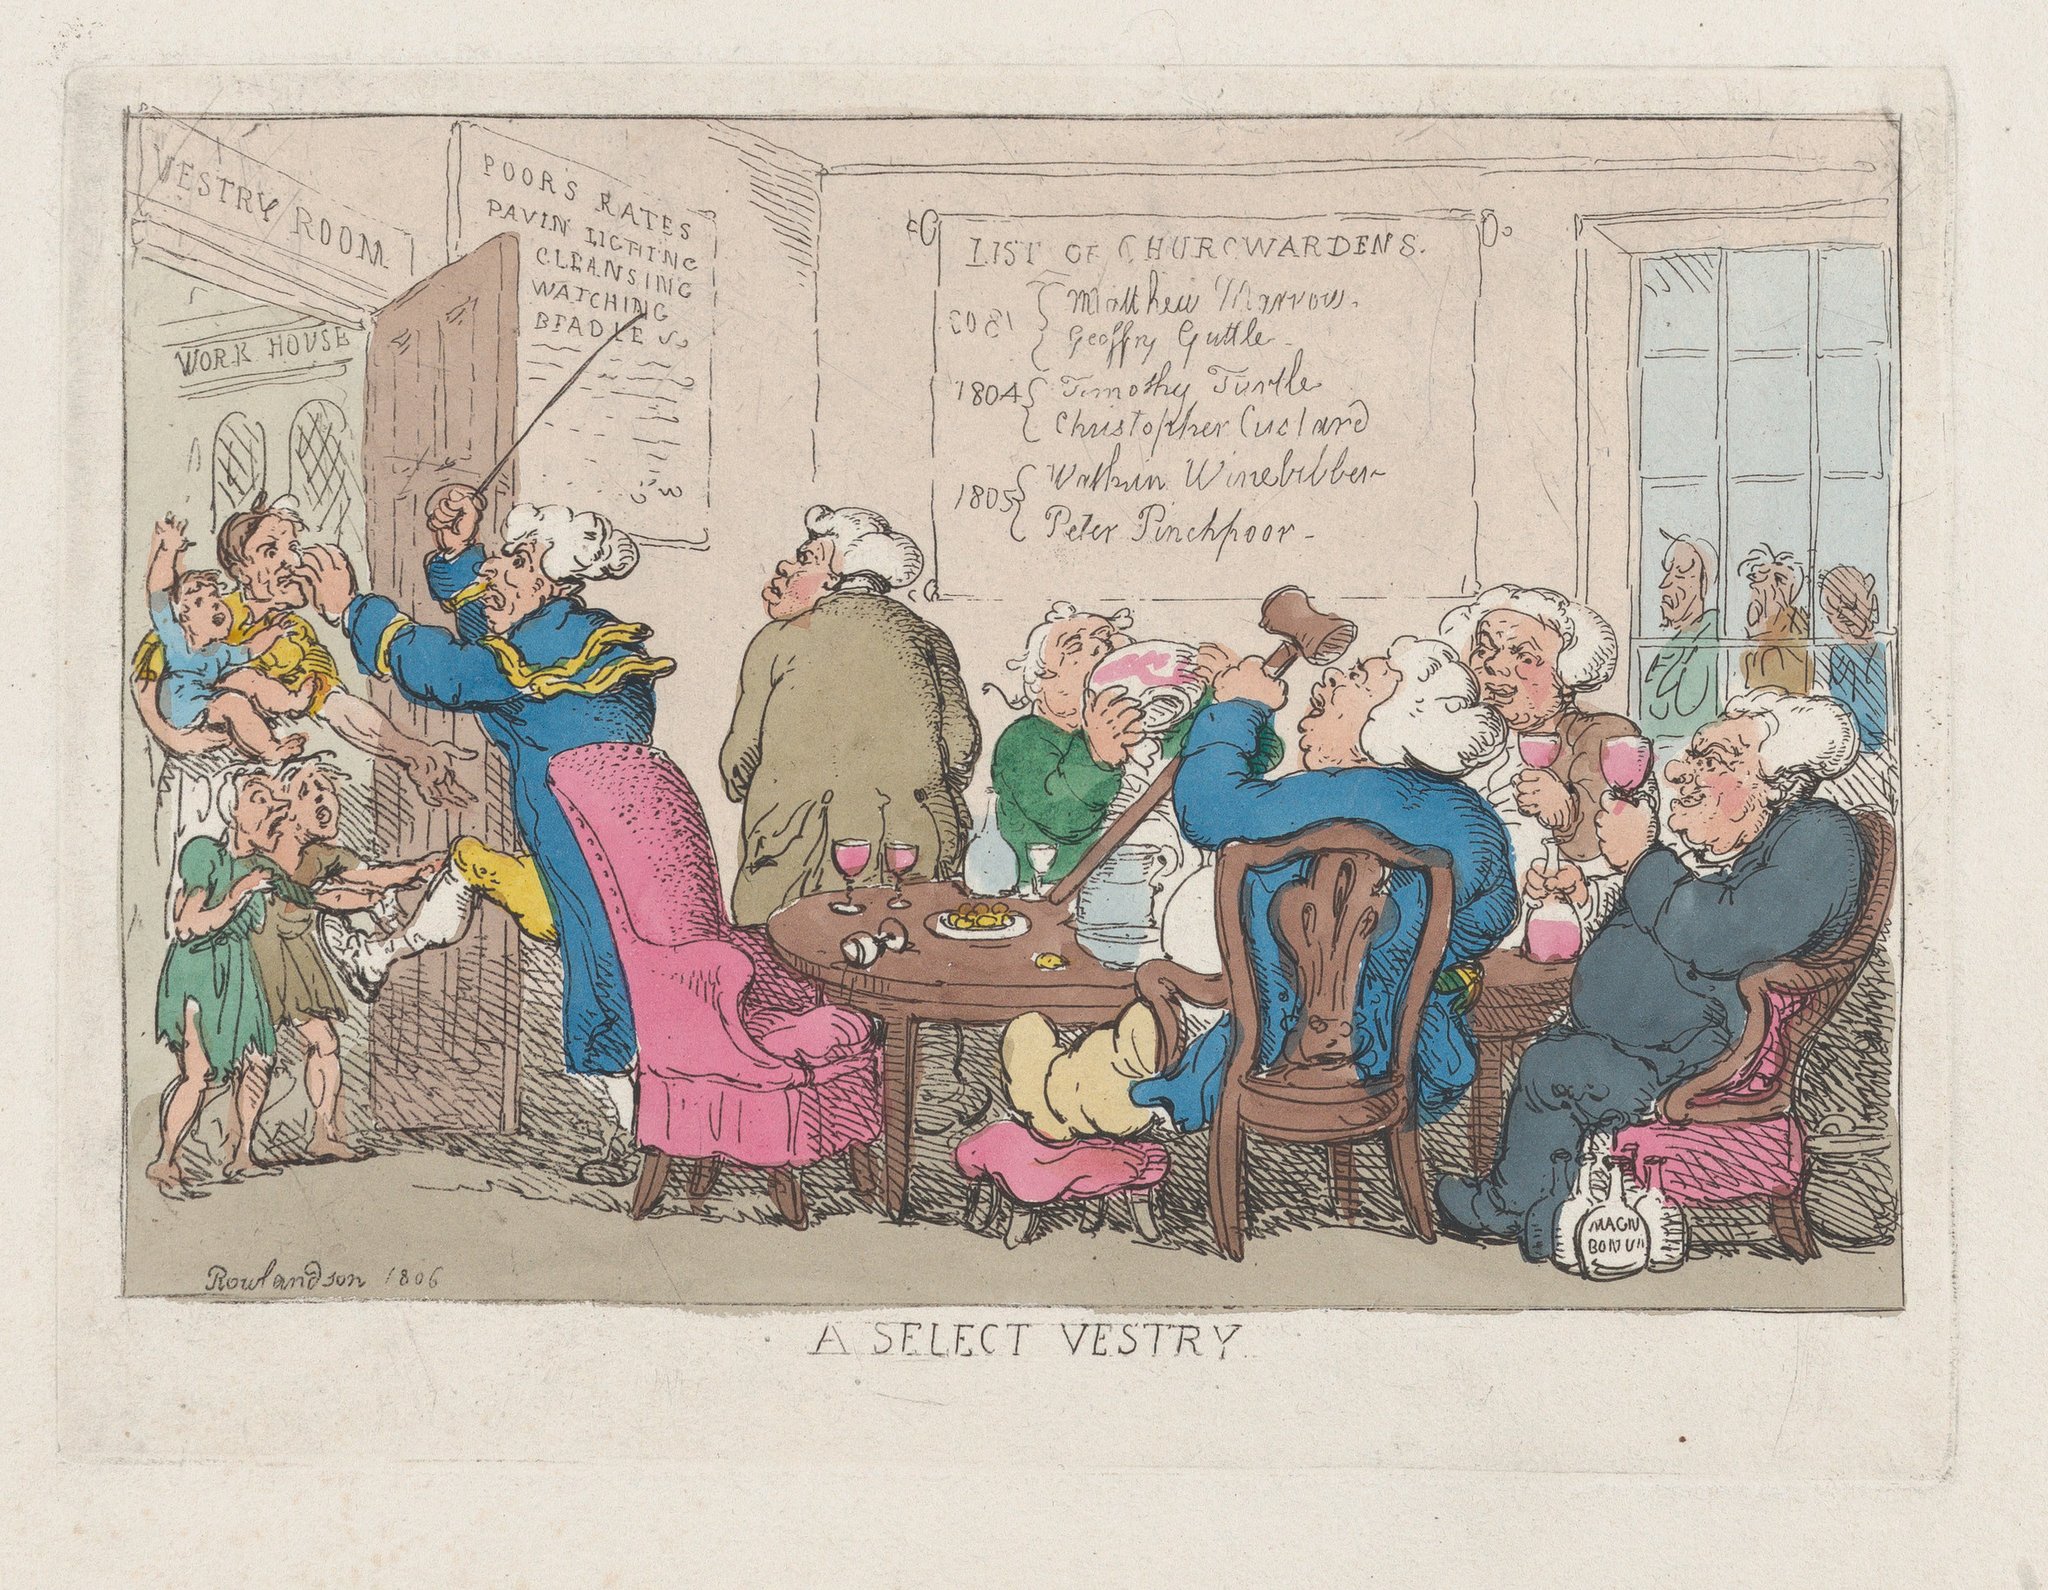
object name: print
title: A Select Vestry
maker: thomas rowlandson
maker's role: artist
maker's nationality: british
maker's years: 1757-1827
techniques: etching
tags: satire,men,women,drinking